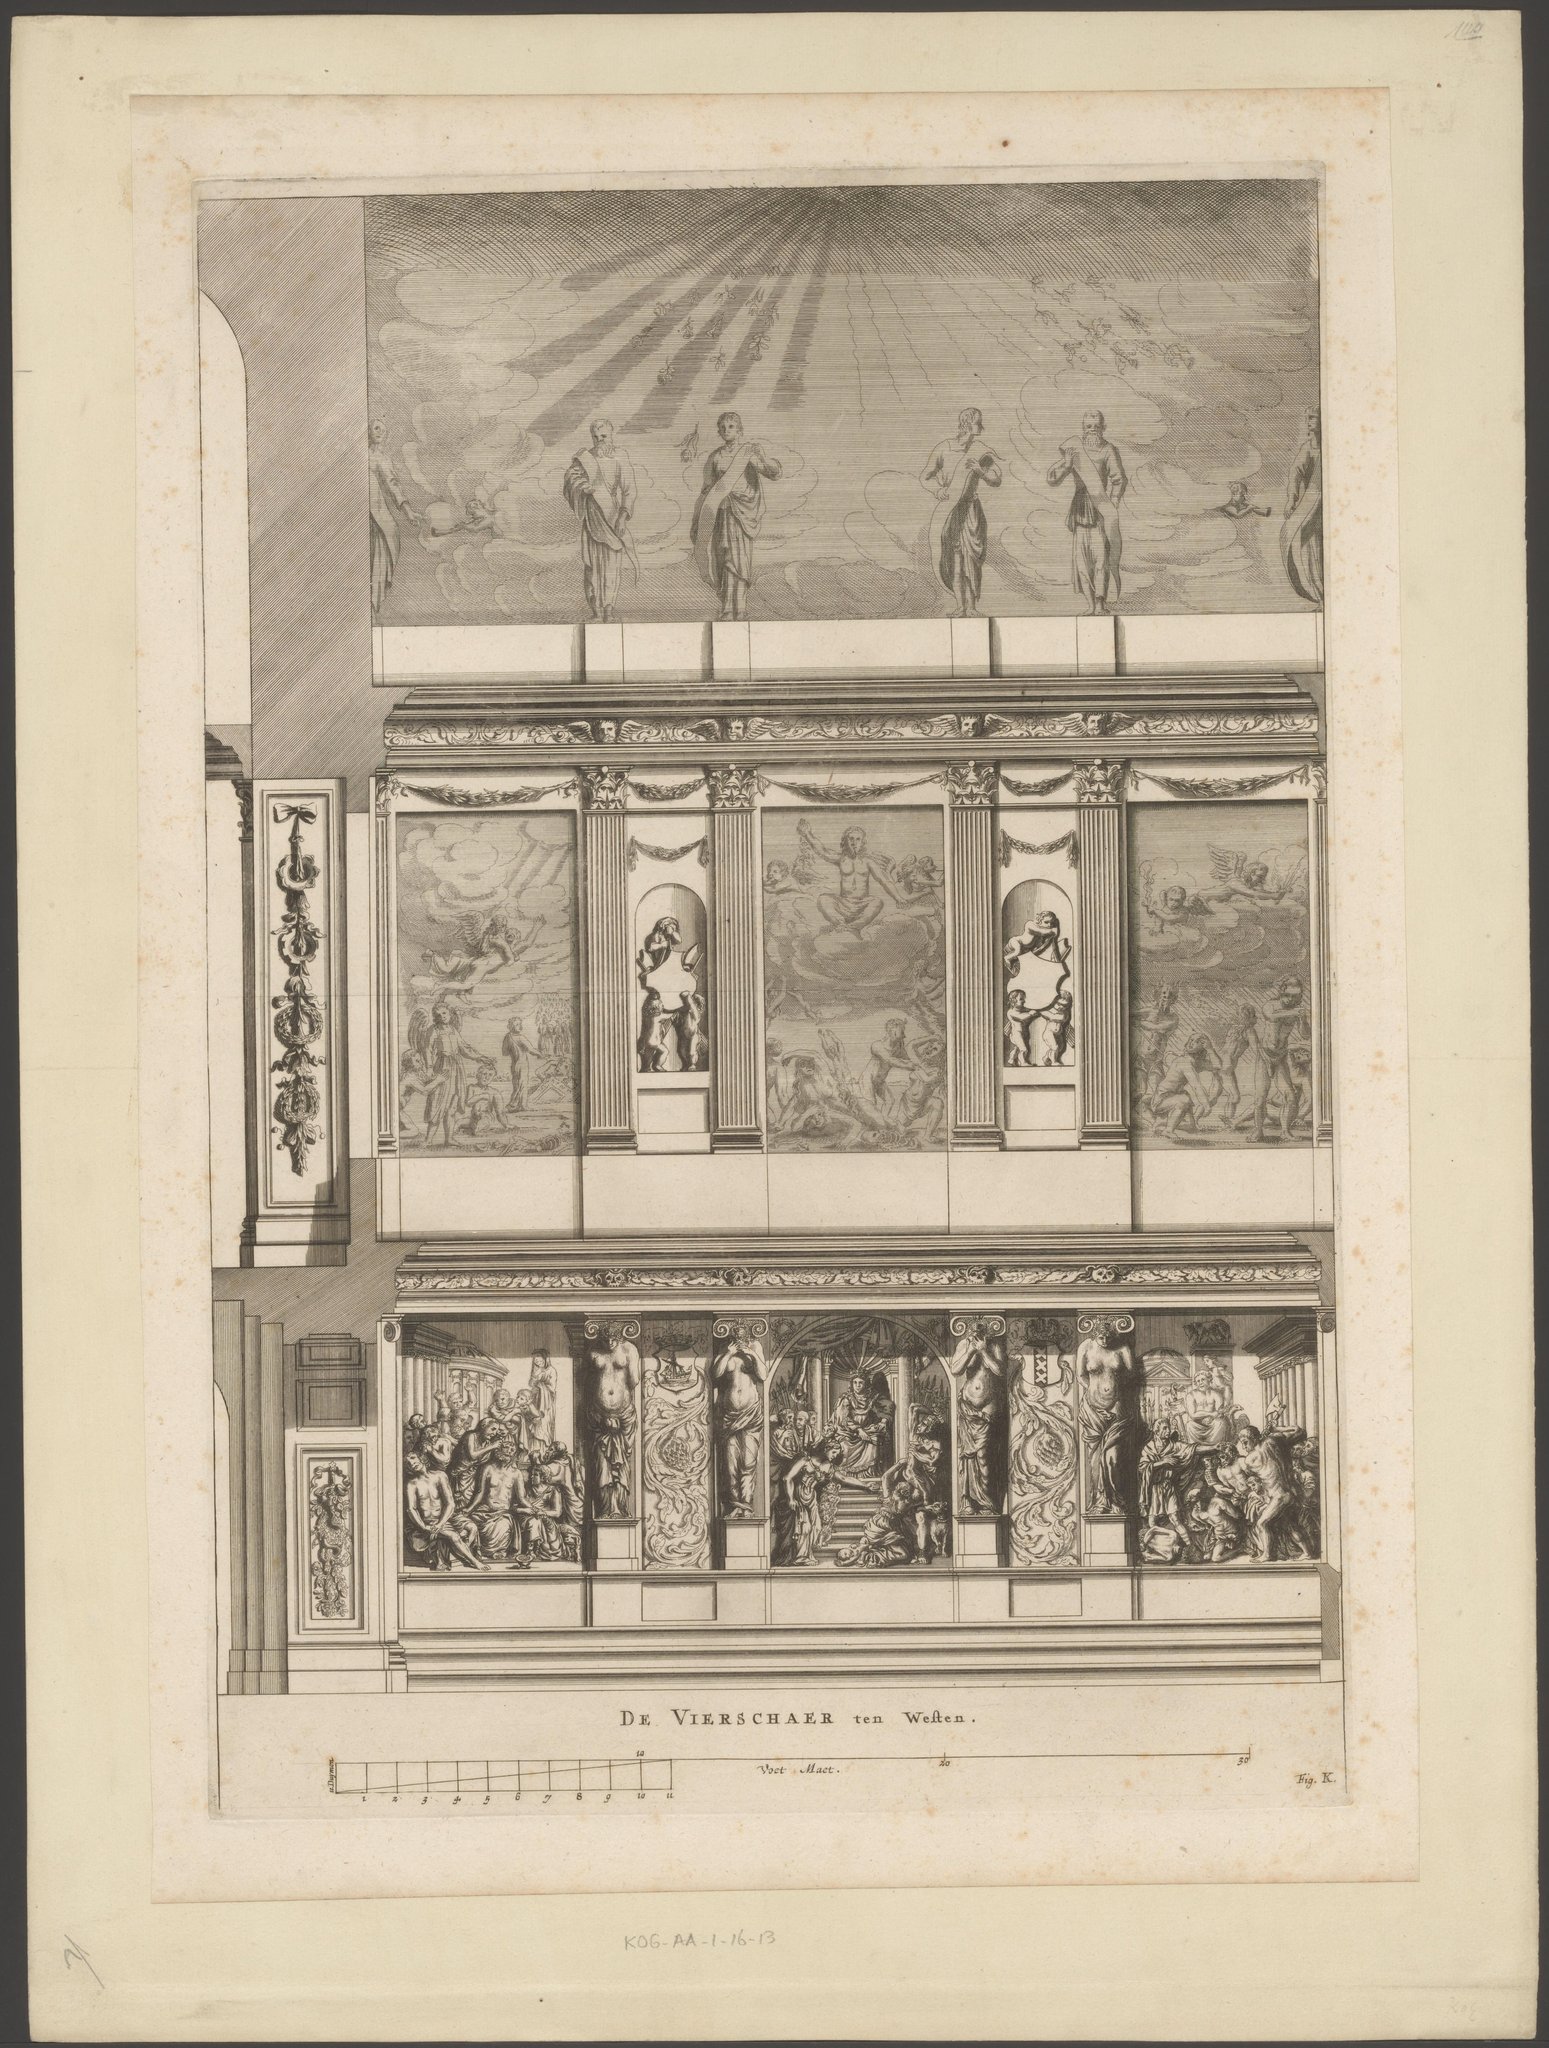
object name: print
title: De Vierschaer ten Westen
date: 1661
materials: paper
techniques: engraving, etching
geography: amsterdam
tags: coat of arms (as symbol of the state, etc.) (+ city; municipal), the judgement of solomon (1 kings 3:16-28), seal (as symbol of the state, etc.) (+ city; municipal), caryatids ~ architecture, l. junius brutus has his two sons beheaded because they joined a conspiracy, interior ~ architectural design or model, the judgement of zaleucus: when zaleucus' son is sentenced to be blinded in both eyes, zaleucus has one of his son's eyes plucked out and one of his own, (story of) romulus and remus, townhall, court-room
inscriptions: collector's mark: ‘16,13’ Lugt 1641b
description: Onderwerpsrubriek binnen de Atlas Amsterdam: Stadhuis op de Dam. Rechtsonder: Fig. K.